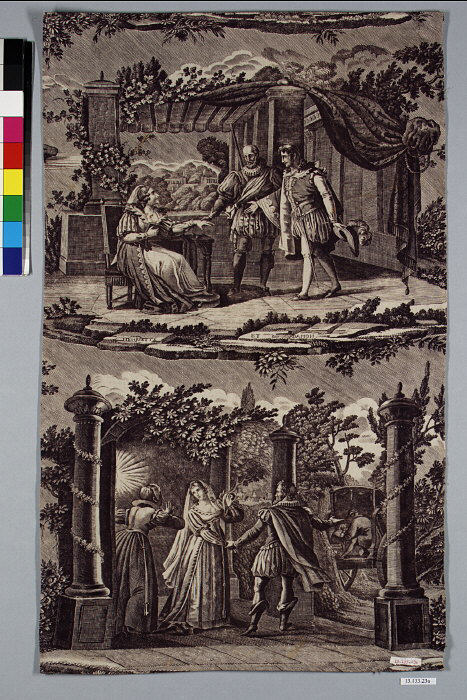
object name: piece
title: Henriette et Damon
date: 1815-1825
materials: cotton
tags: men,women